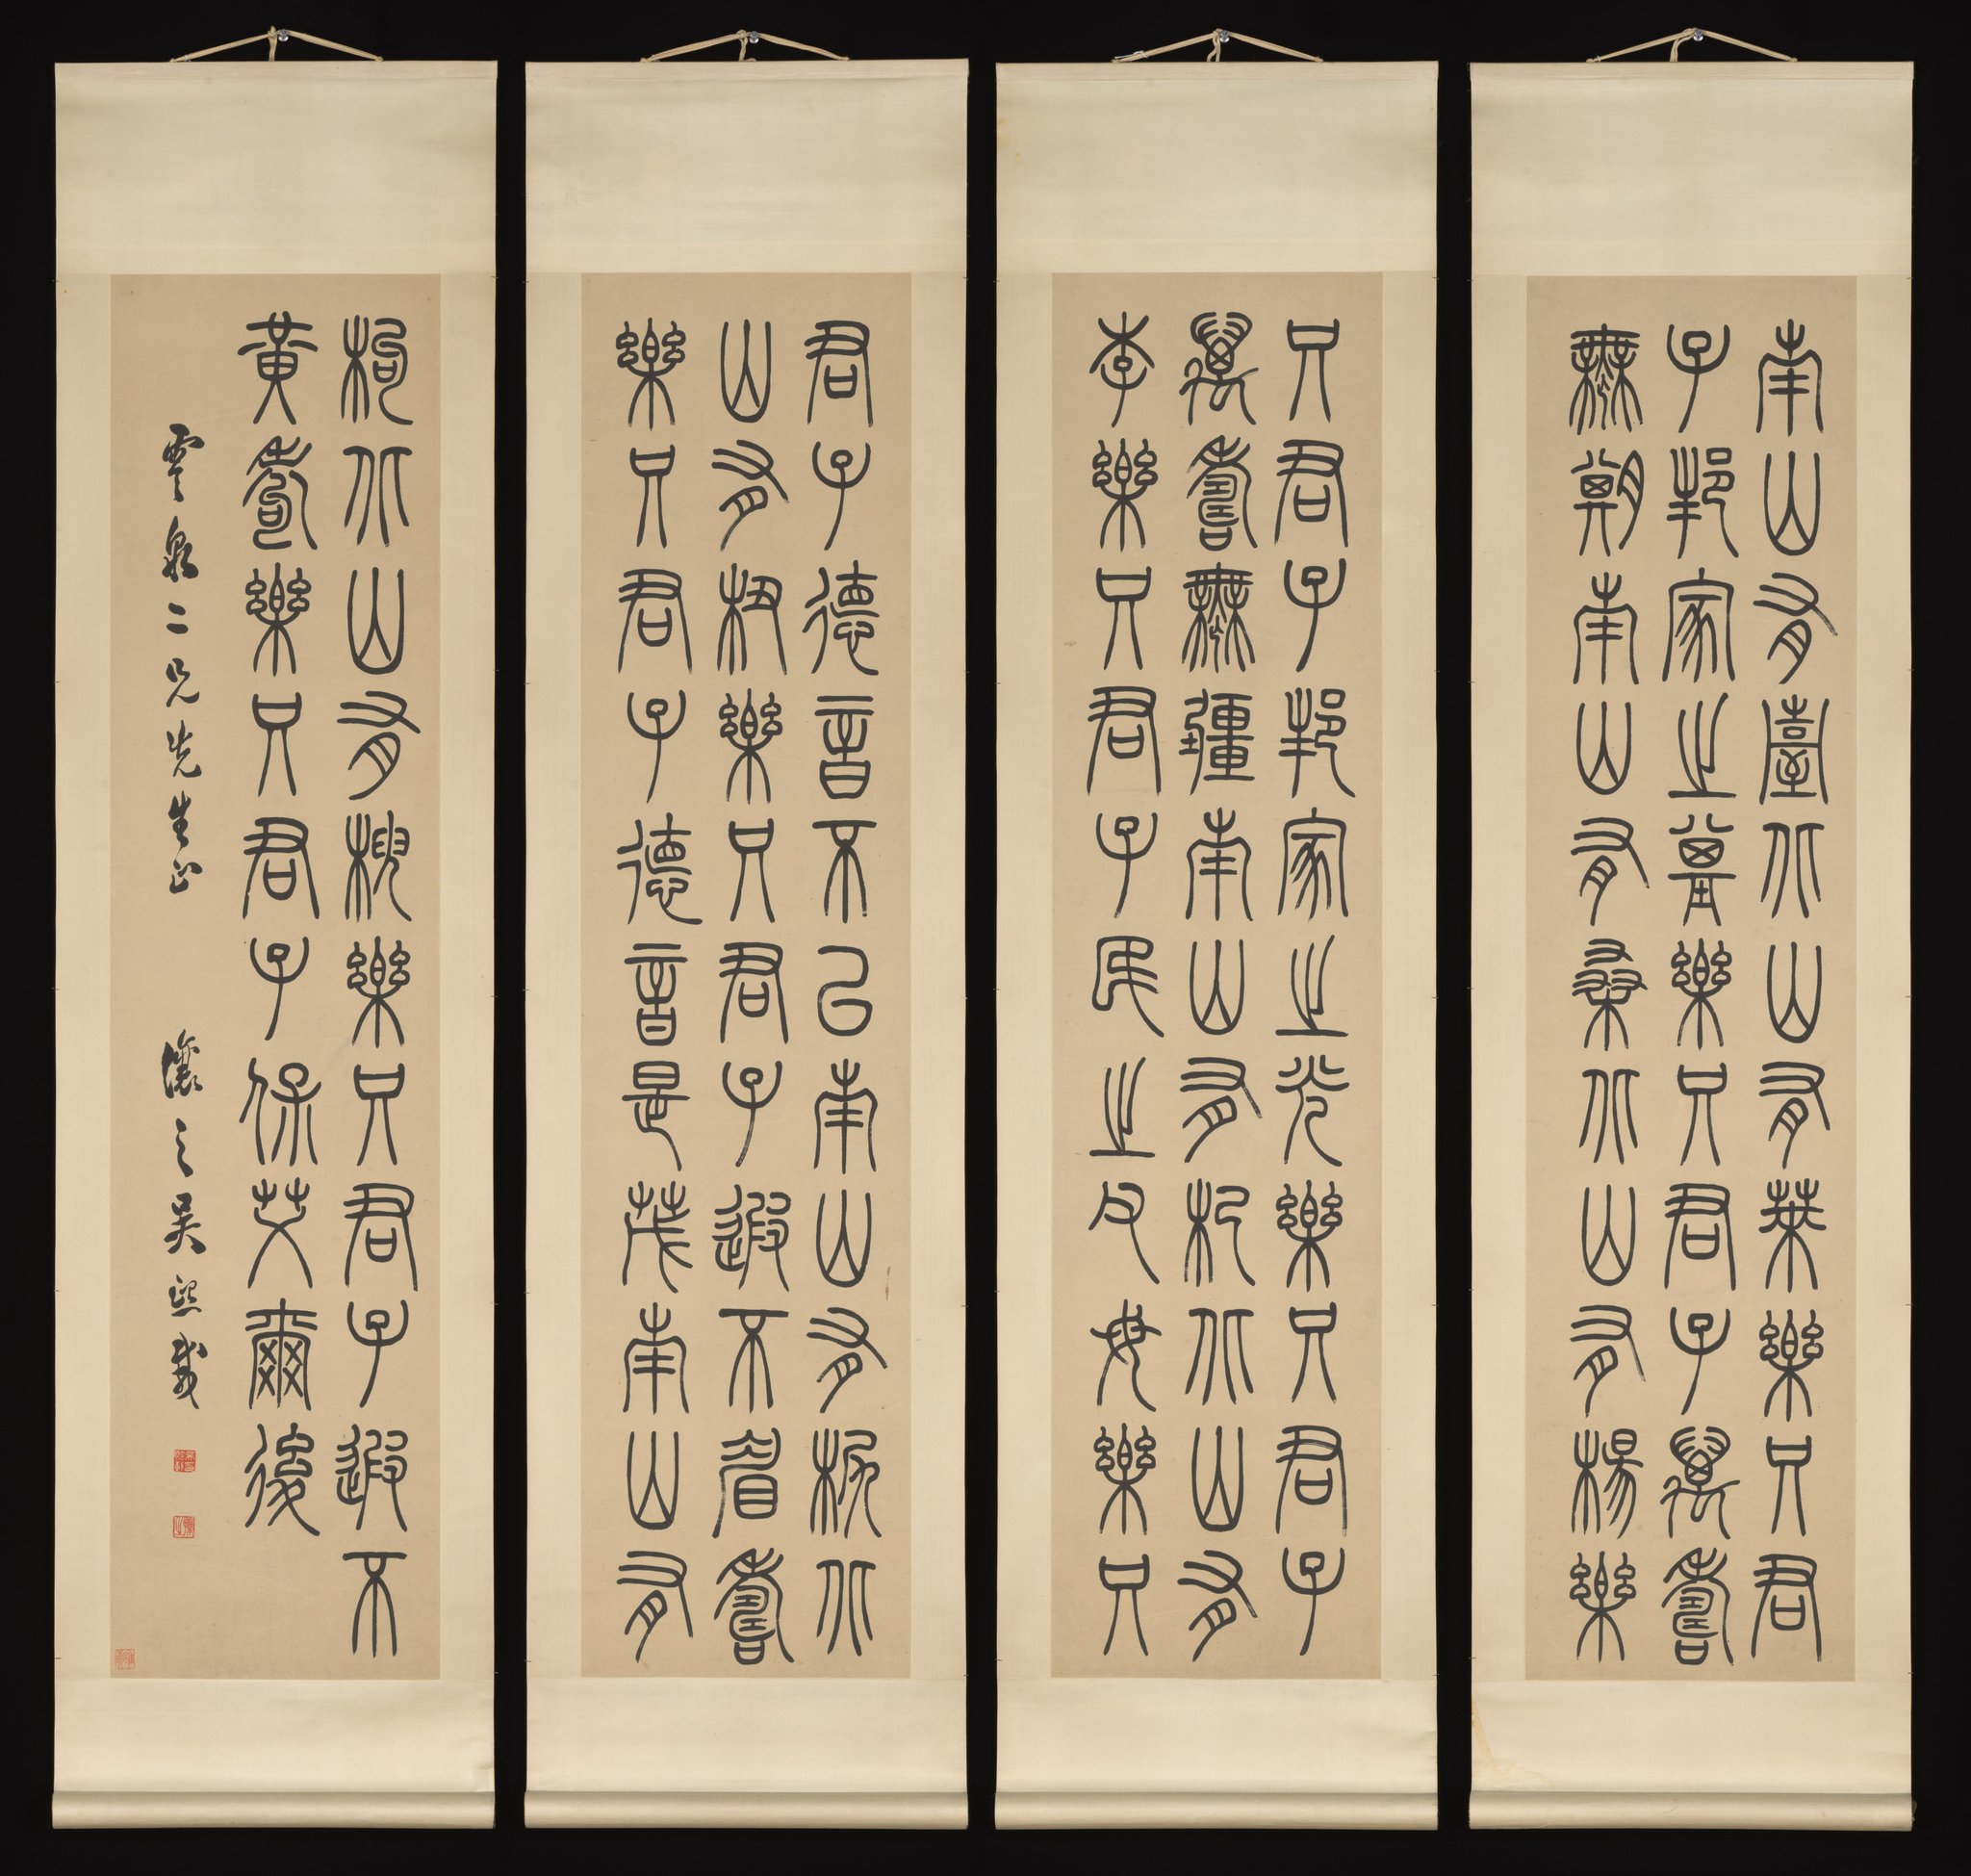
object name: hanging scroll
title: Nutgrass Grows on the Southern Hills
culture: chinese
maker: wu xizai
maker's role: artist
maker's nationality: chinese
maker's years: 1799-1870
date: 1862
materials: ink, paper